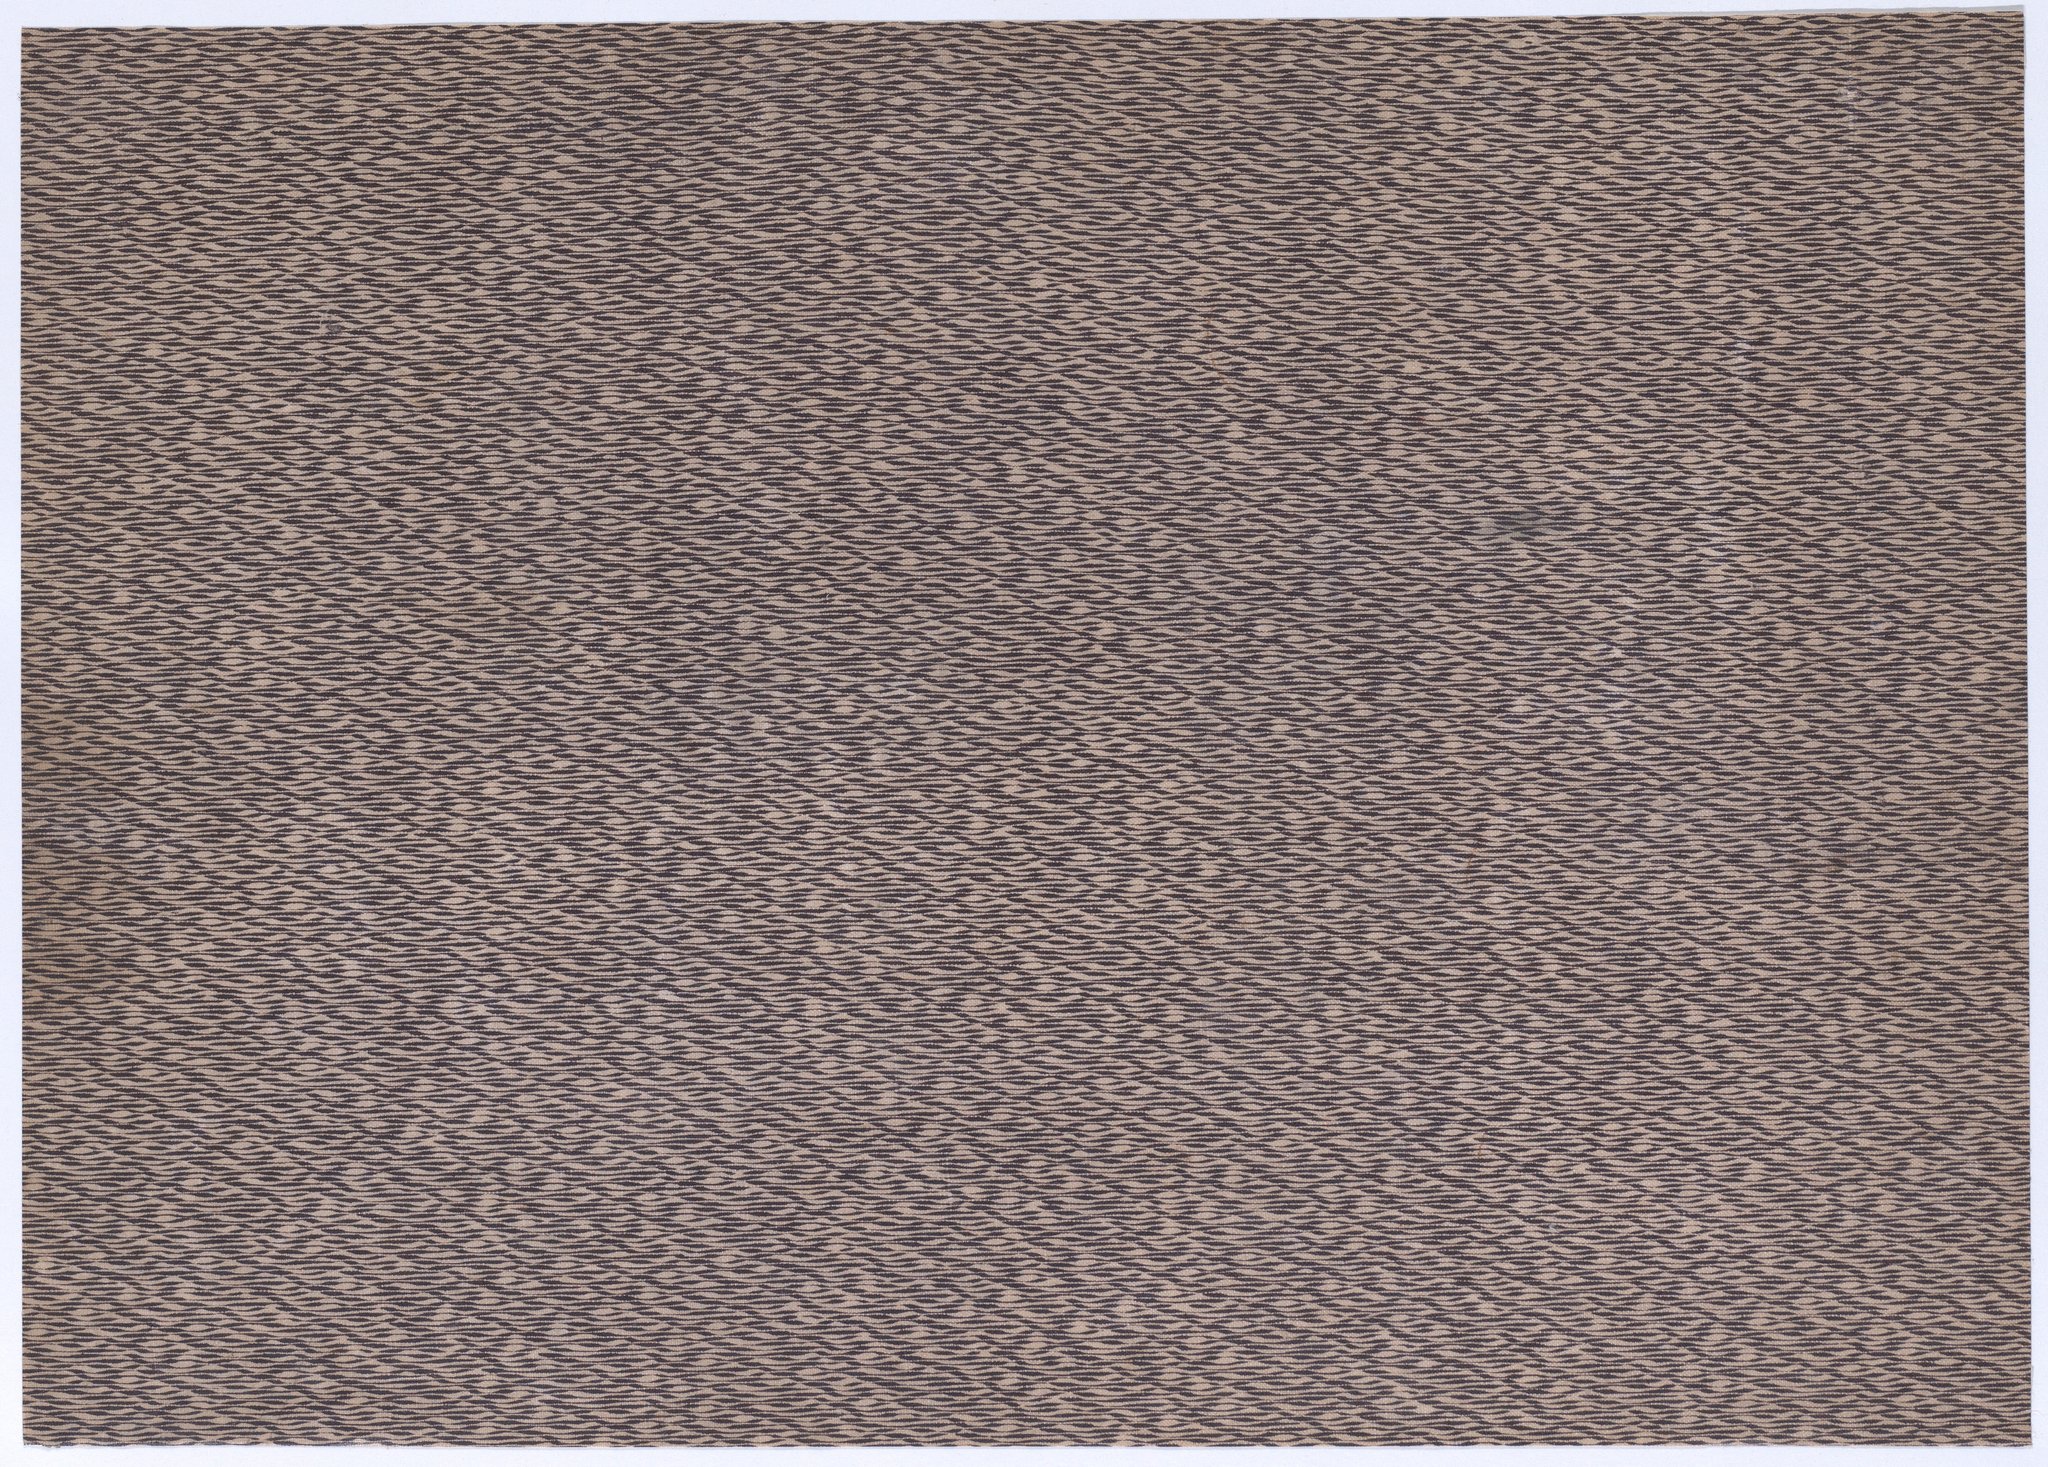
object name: book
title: Domestic Architecture: Being a Second Series of Designs for Cottages, Lodges, Villas and Other Residences, in the Grecian, Italian, and Old English Styles of Architecture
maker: francis goodwin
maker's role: architect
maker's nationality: british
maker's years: 1784-1834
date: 1834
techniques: aquatint, engraving, etching, hand coloring